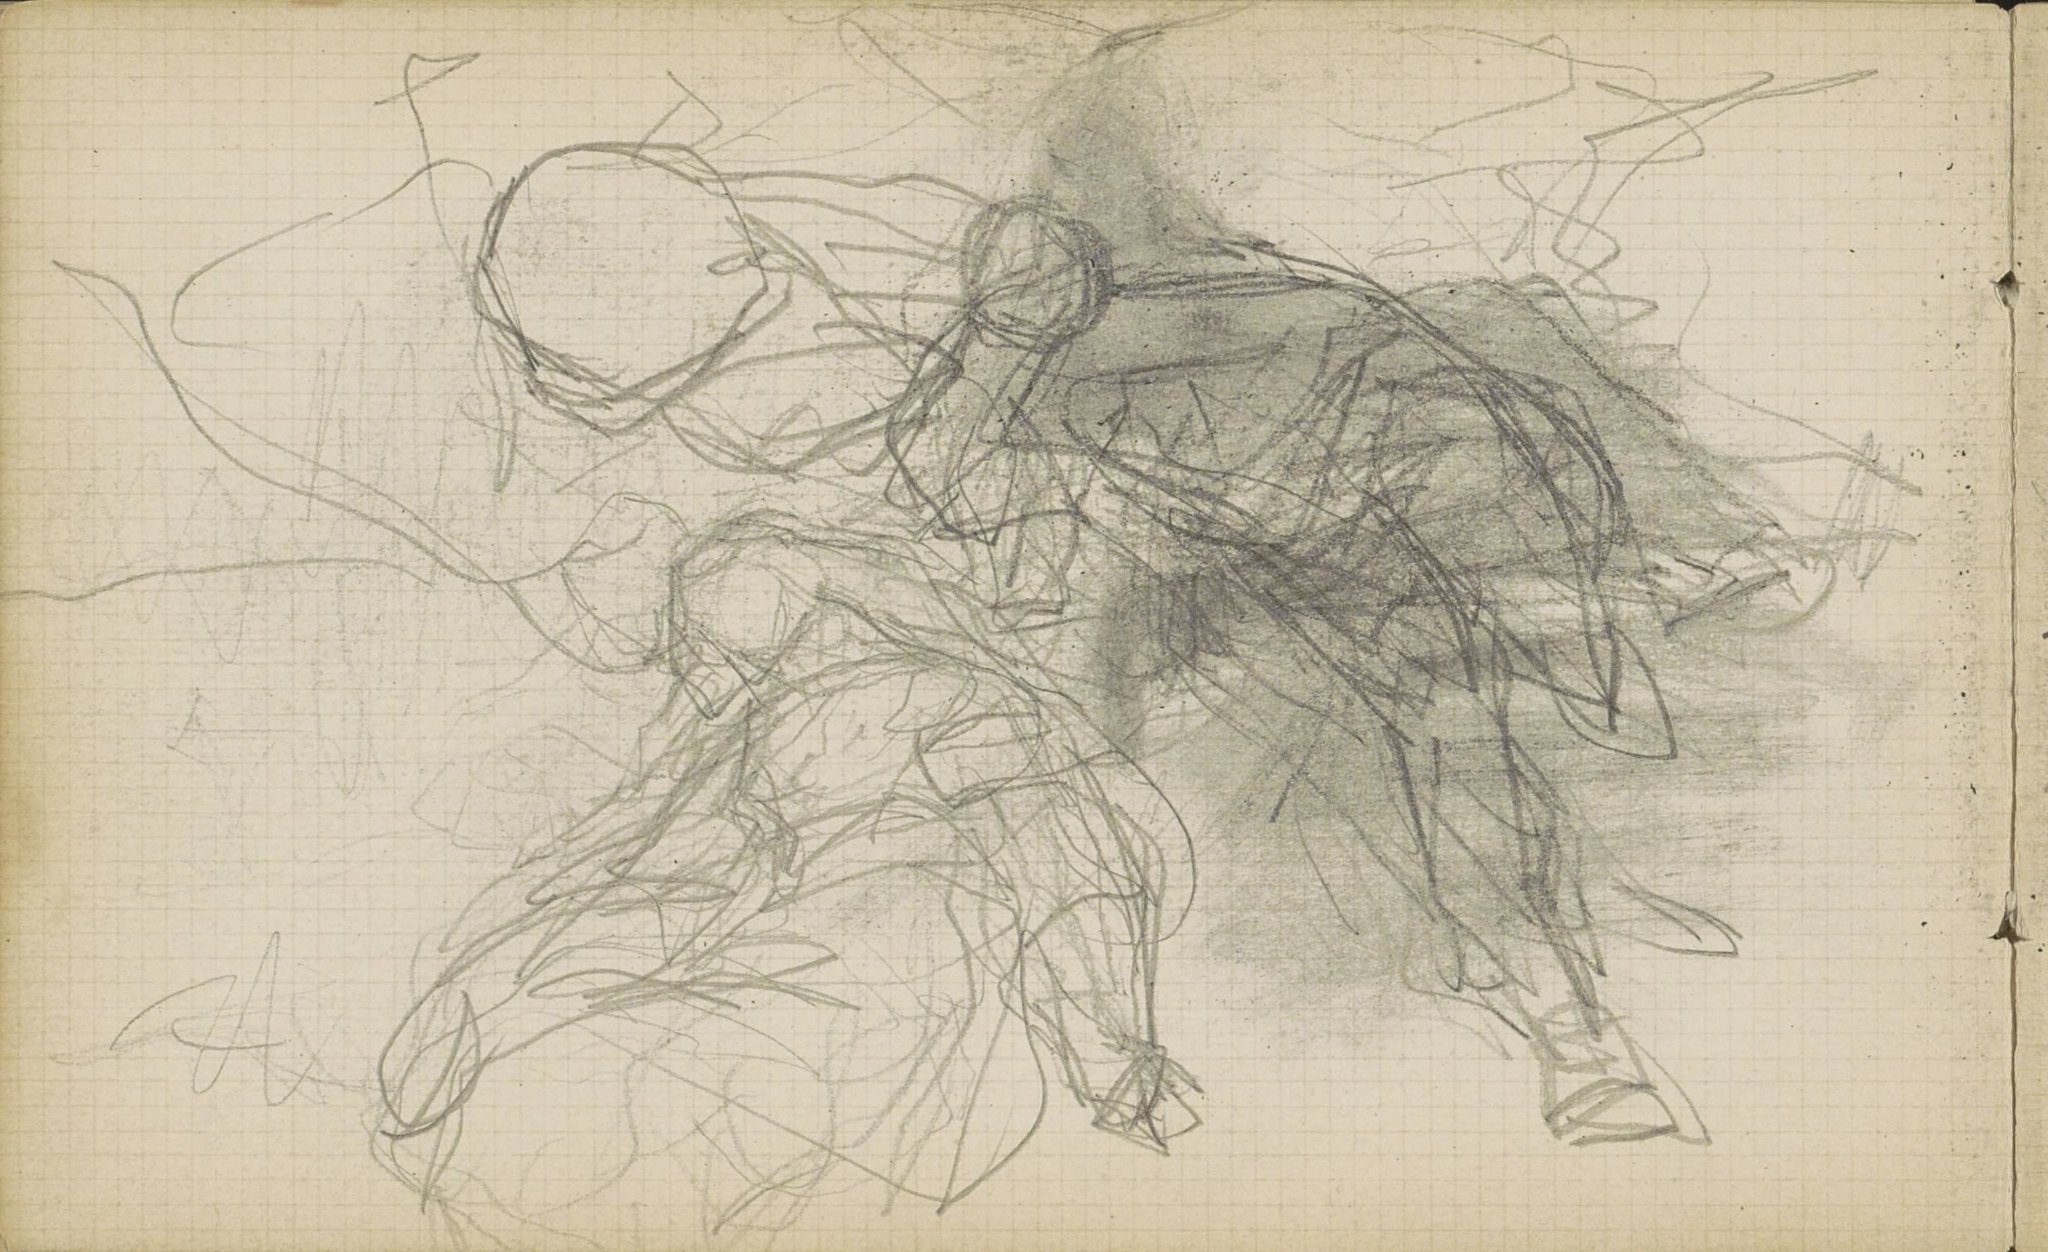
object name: sketchbook leaf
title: Figuurstudies, waaronder een zittende vrouw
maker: matthijs maris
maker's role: draughtsman, painter, print maker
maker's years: 1839-1917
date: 1849-1917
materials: pencil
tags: sitting figure (+ female (human being) (not to be used where -aa- is prescribed))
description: Blad 26 verso uit een schetsboek met 35 bladen.